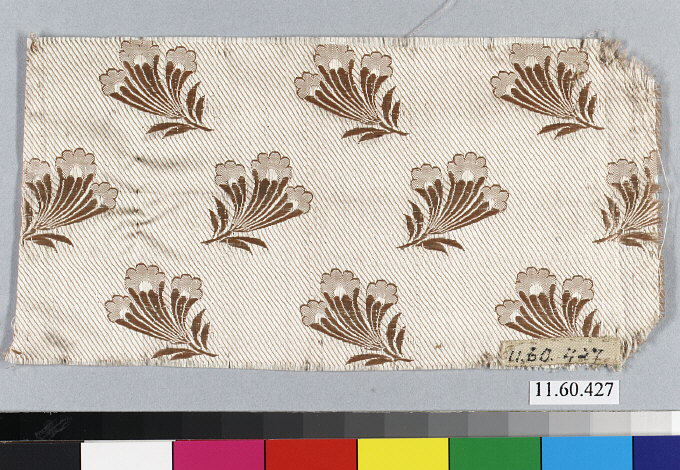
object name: fragment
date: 1801-1900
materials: silk